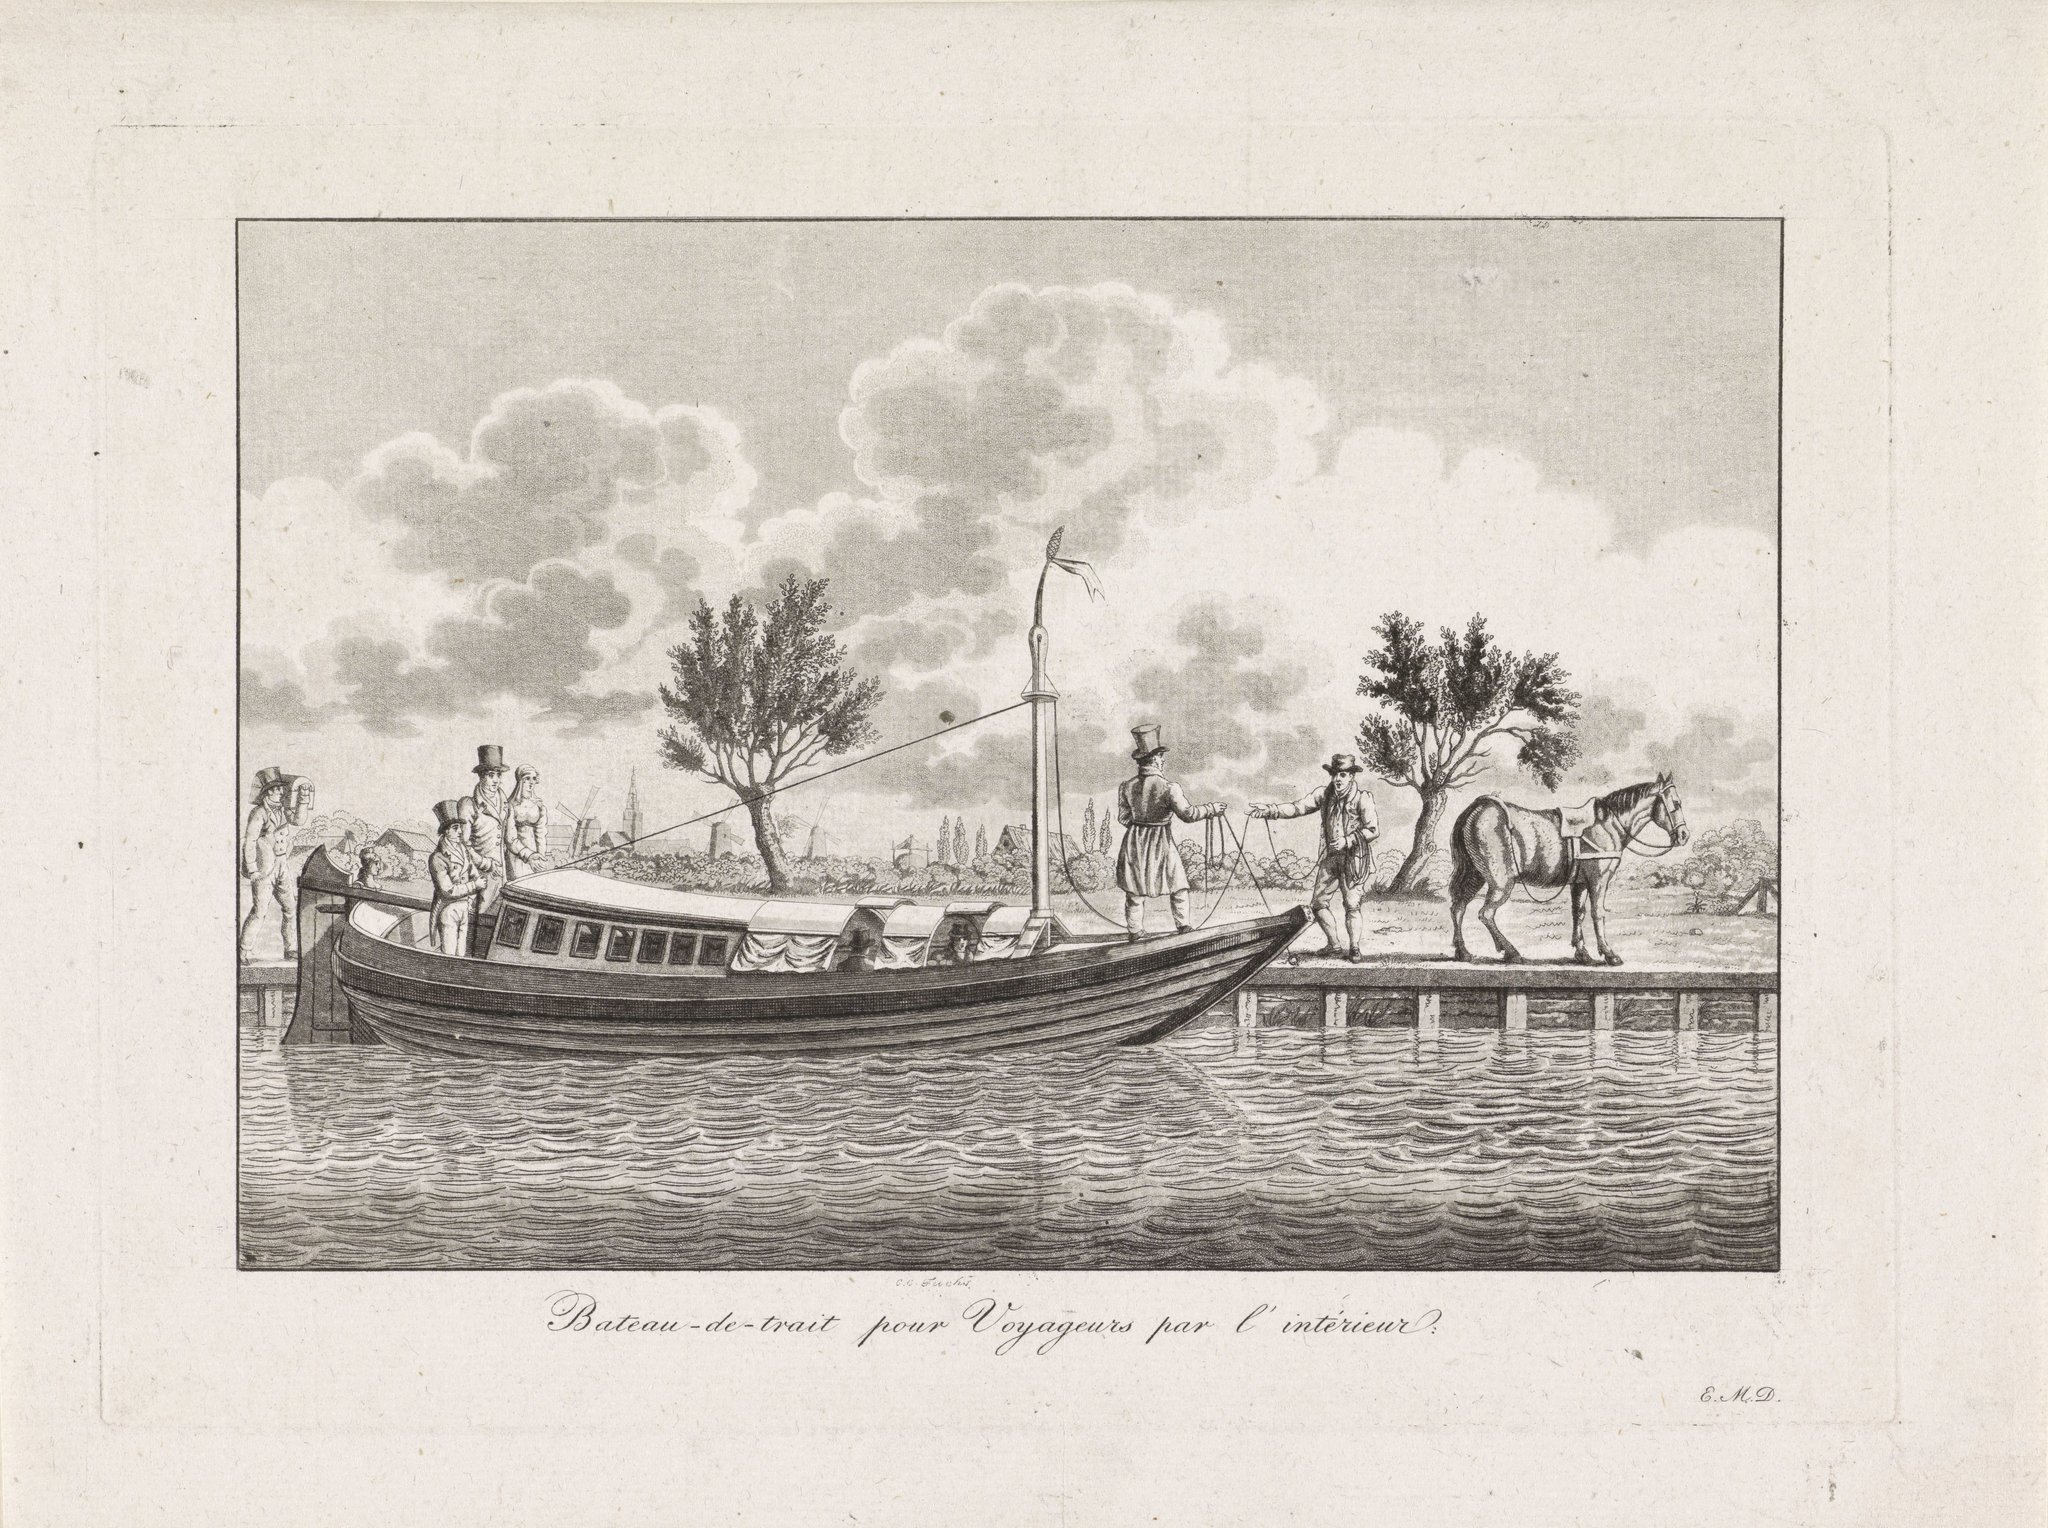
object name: print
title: Trekschuit, ca. 1830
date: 1825-1835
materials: paper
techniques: aquatint, etching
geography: amsterdam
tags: tow-boat, towing-barge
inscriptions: collector's mark: Lugt 2228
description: Trekschuit voor vervoer op de binnenwateren, ca. 1830. Een man geeft de lijn aan een man op het jaagpad om vast te maken aan het paard, ca. 1830.